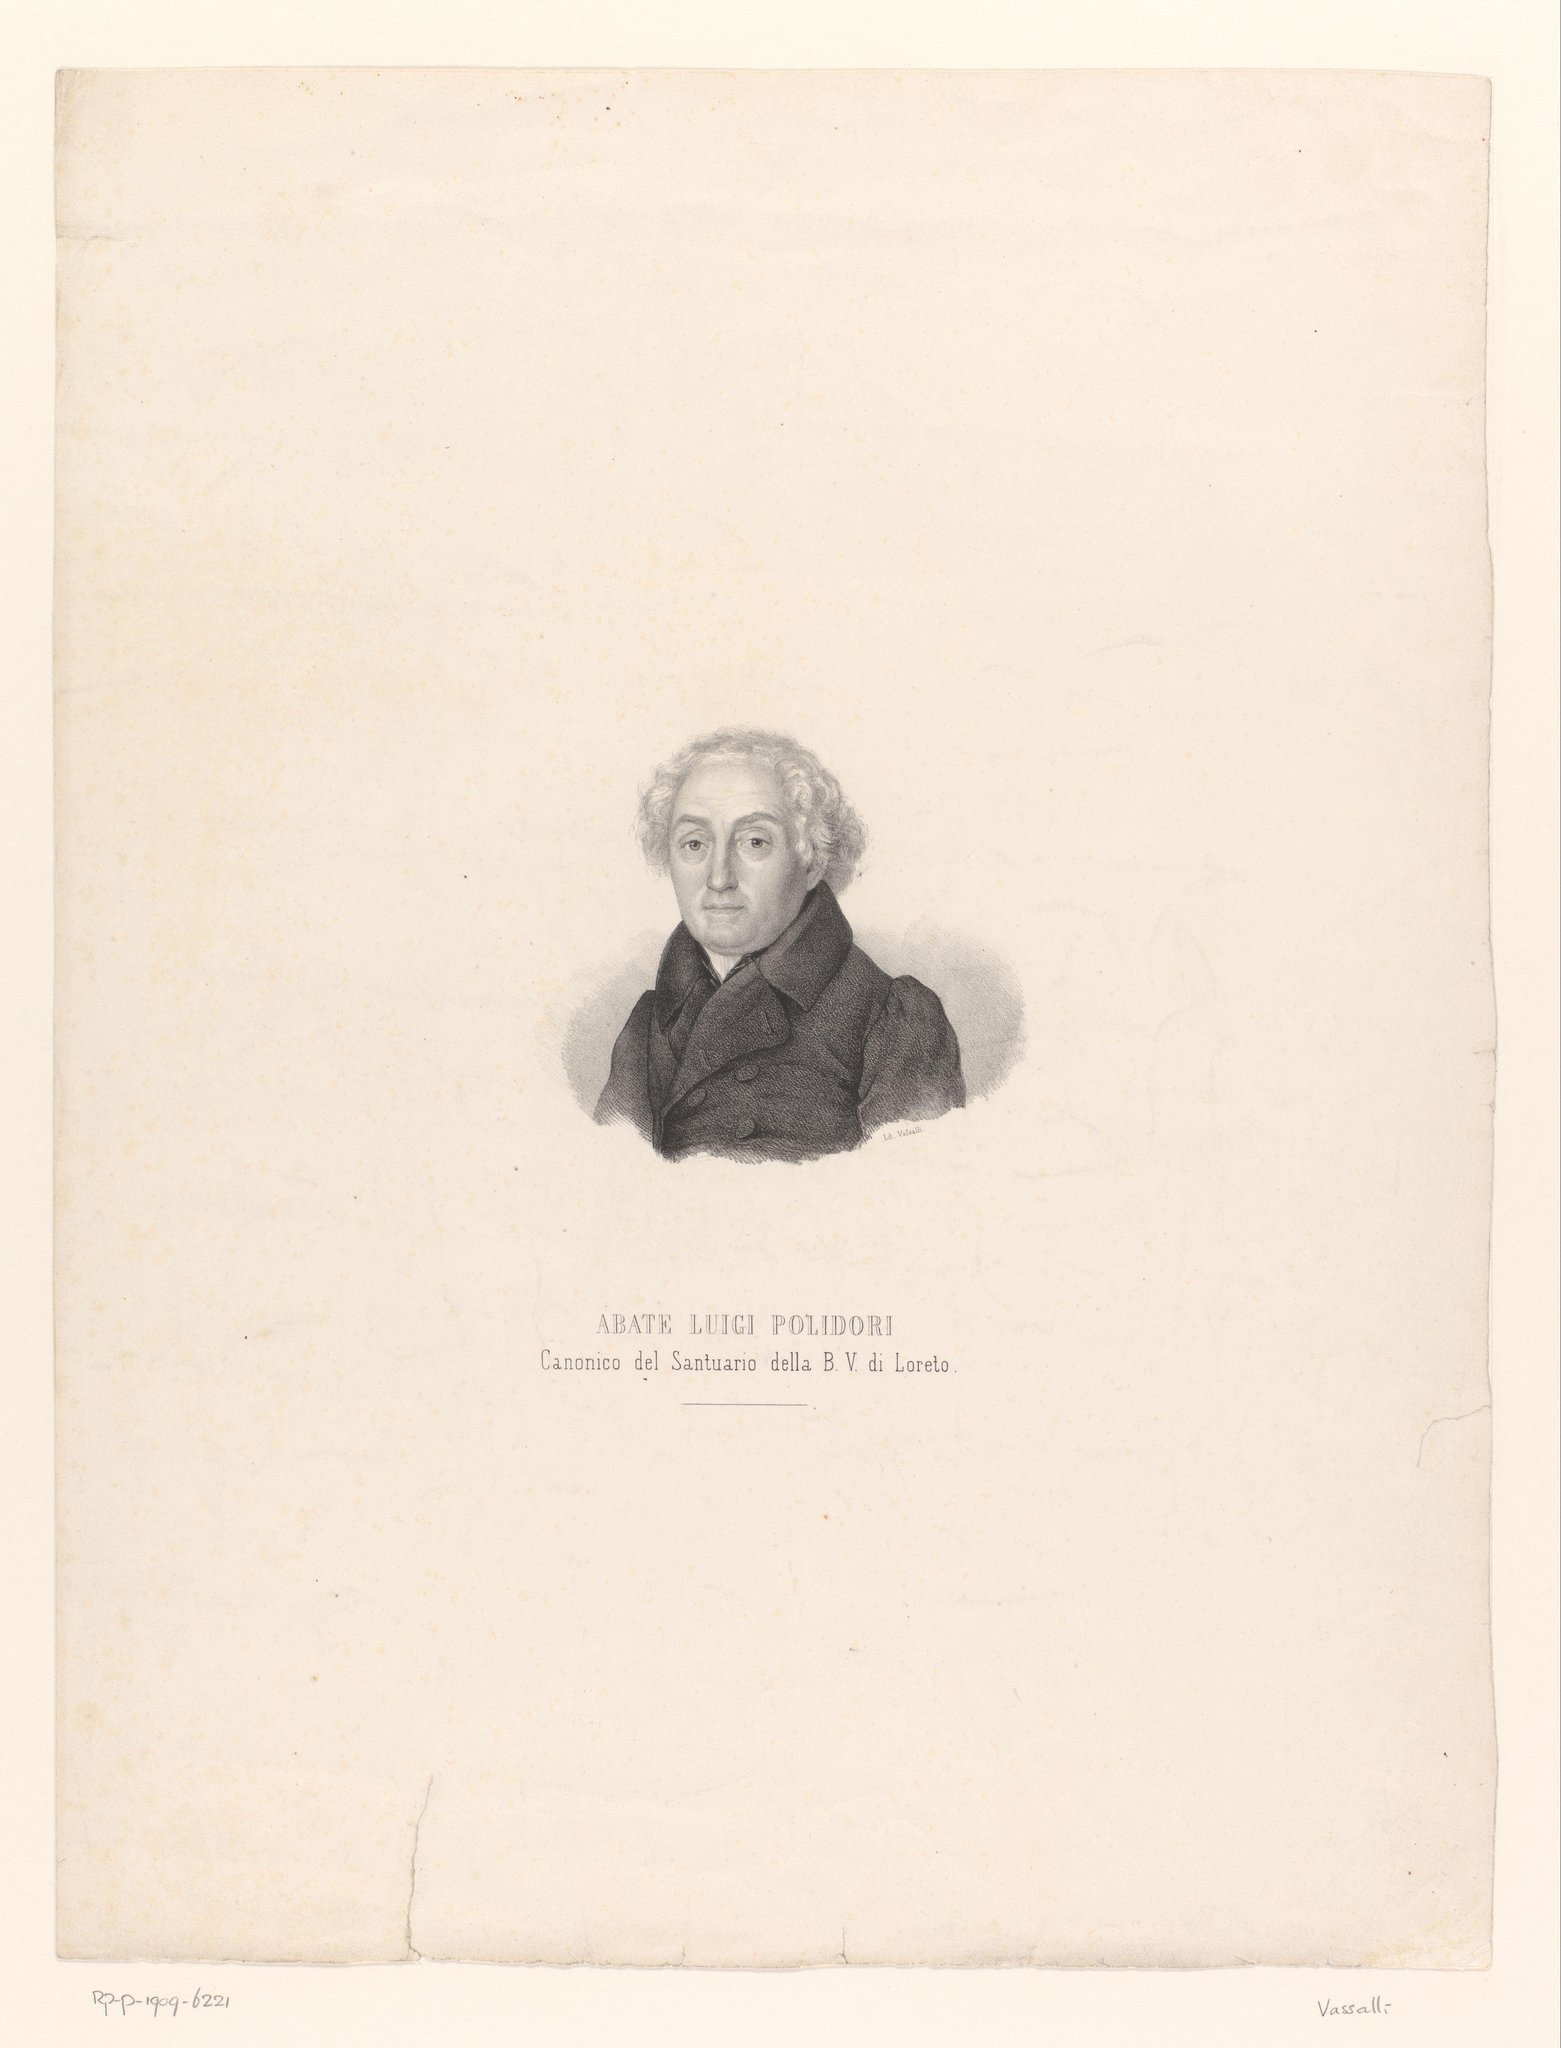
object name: print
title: Portret van abt Luigi Polidori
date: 1800-1899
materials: paper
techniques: lithograph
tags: abbot, historical persons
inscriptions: collector's mark: Lugt 2228